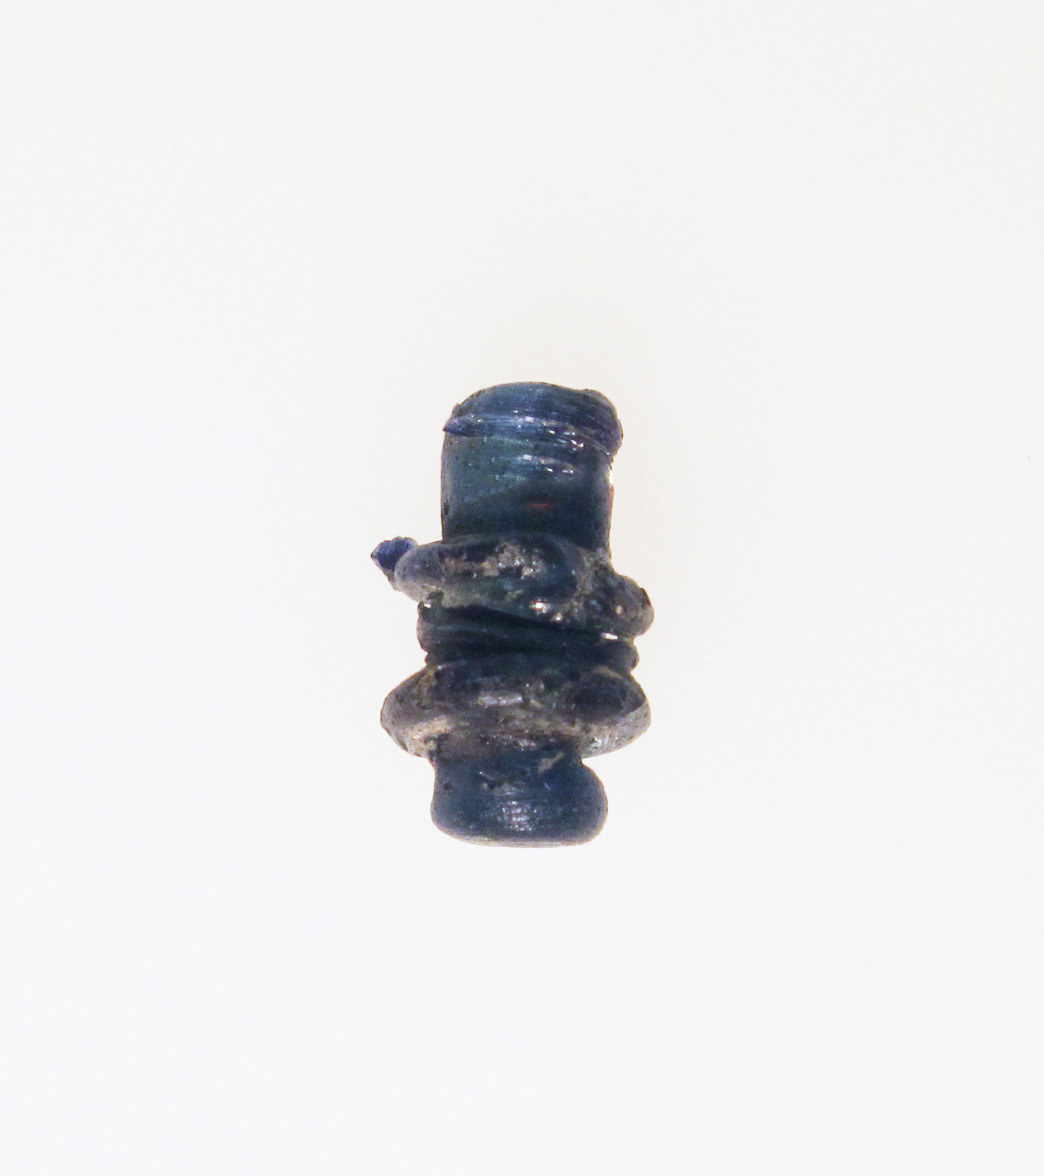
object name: pendant in the form of a vase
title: Glass pendant in the form of a vase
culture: roman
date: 301-433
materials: glass